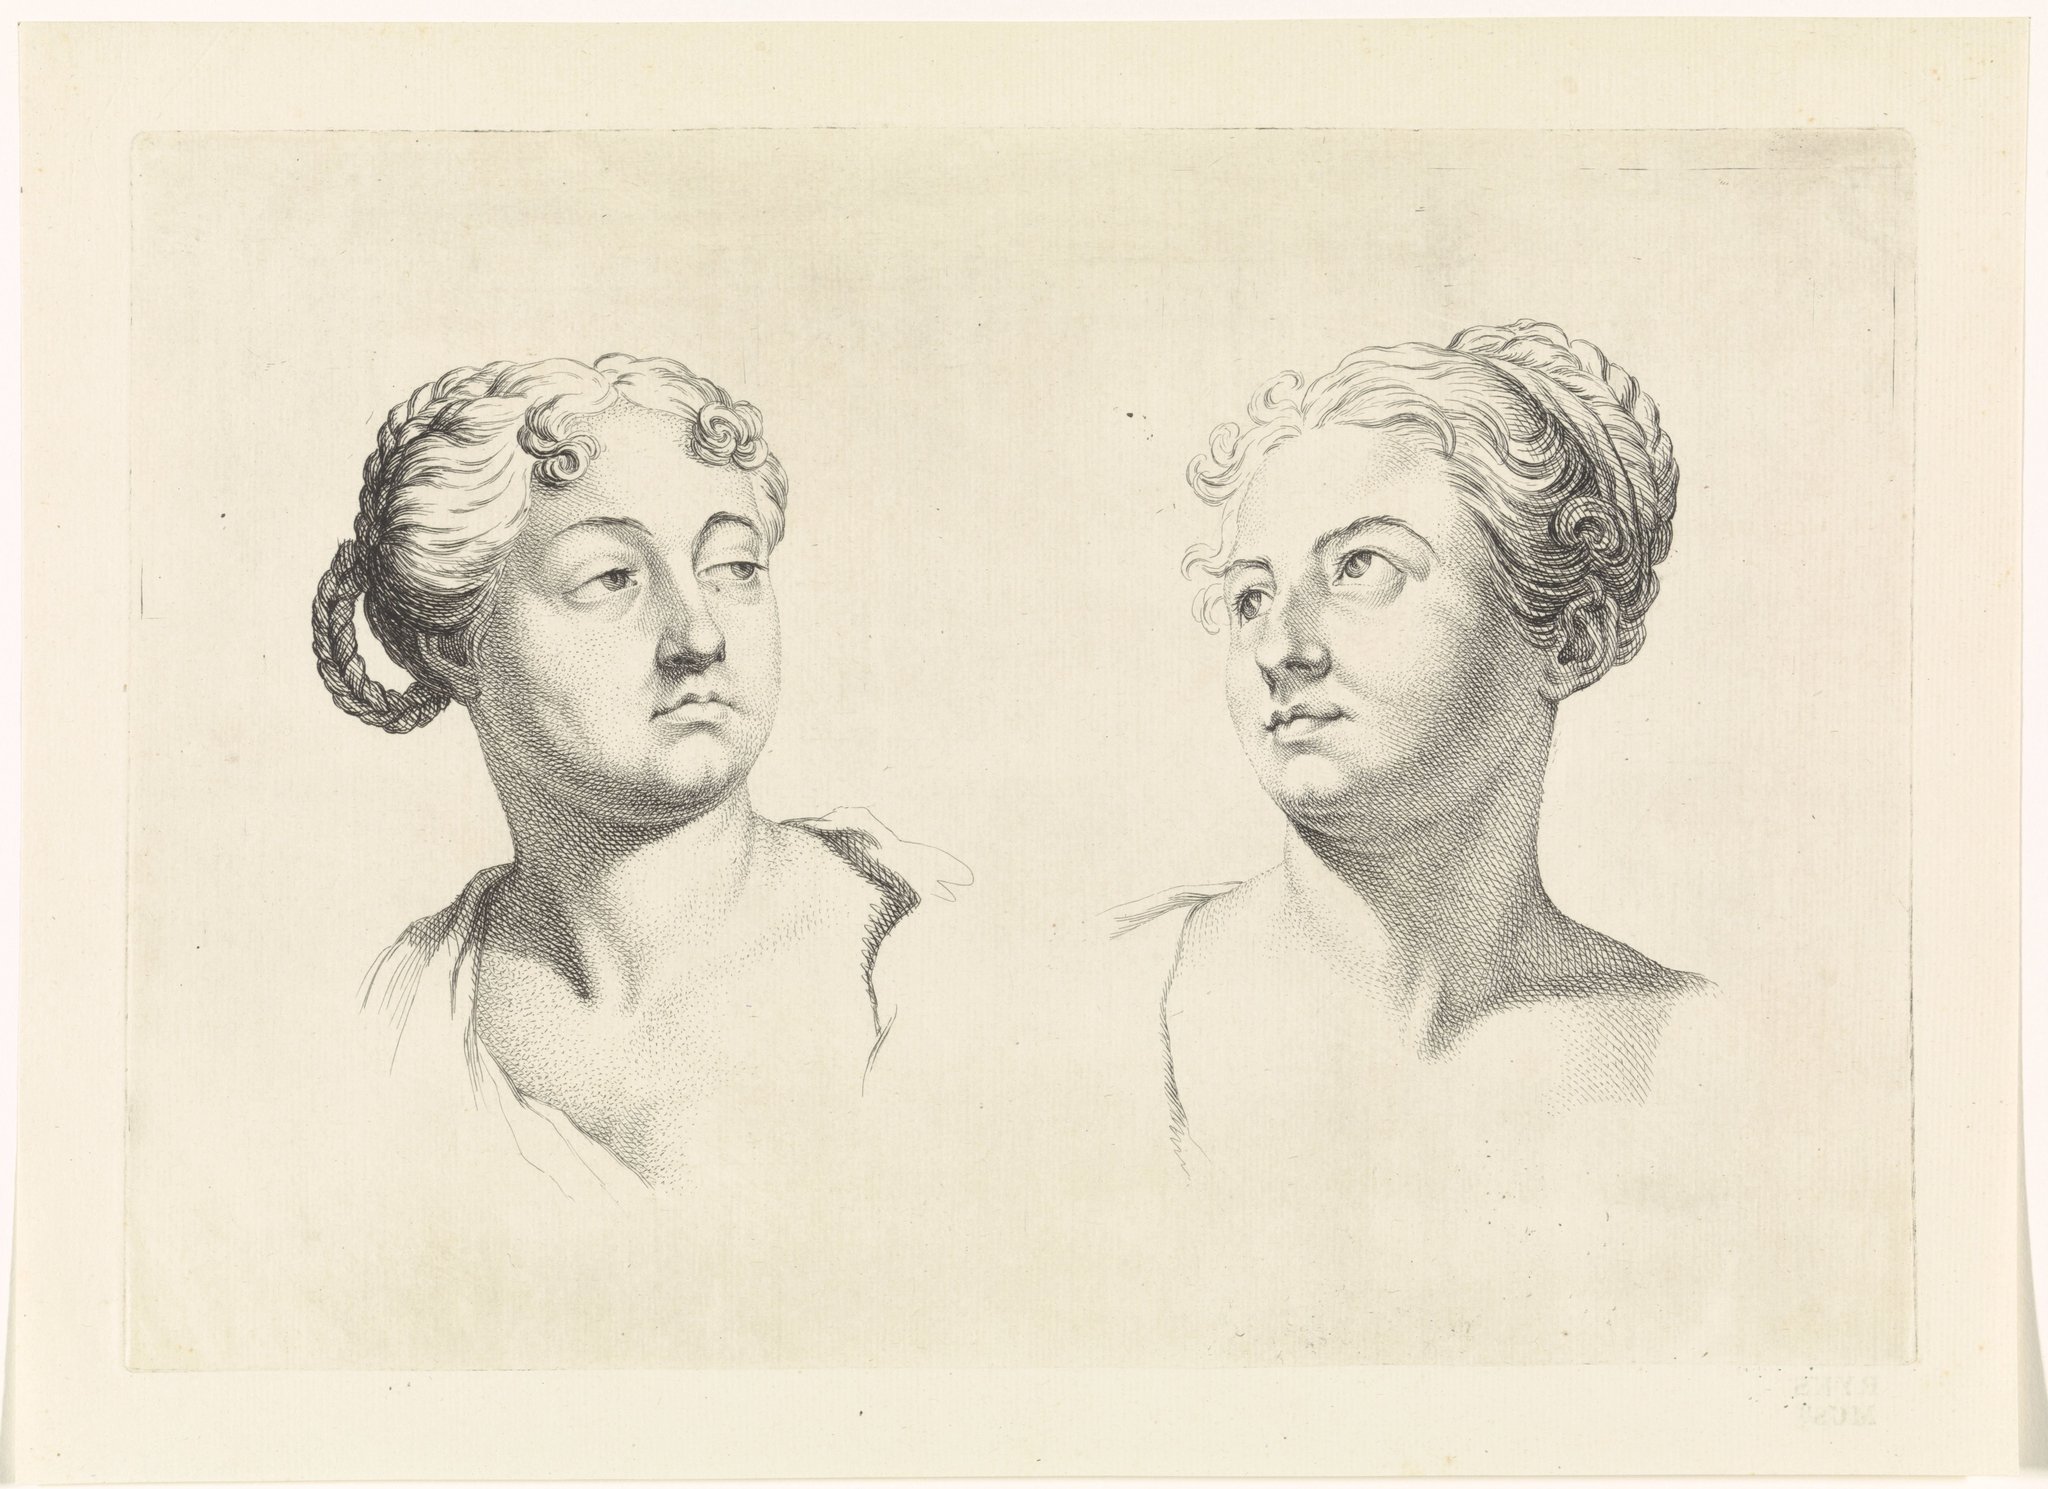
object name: print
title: Studies van twee vrouwenhoofden, met gevlochten haren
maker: bernard picart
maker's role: draughtsman, print maker, publisher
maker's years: 1673-1733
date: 1683-1733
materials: paper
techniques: engraving, etching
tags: adult woman, styles of hairdress - aa - ~ women, postures of the head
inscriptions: collector's mark: Lugt 2165